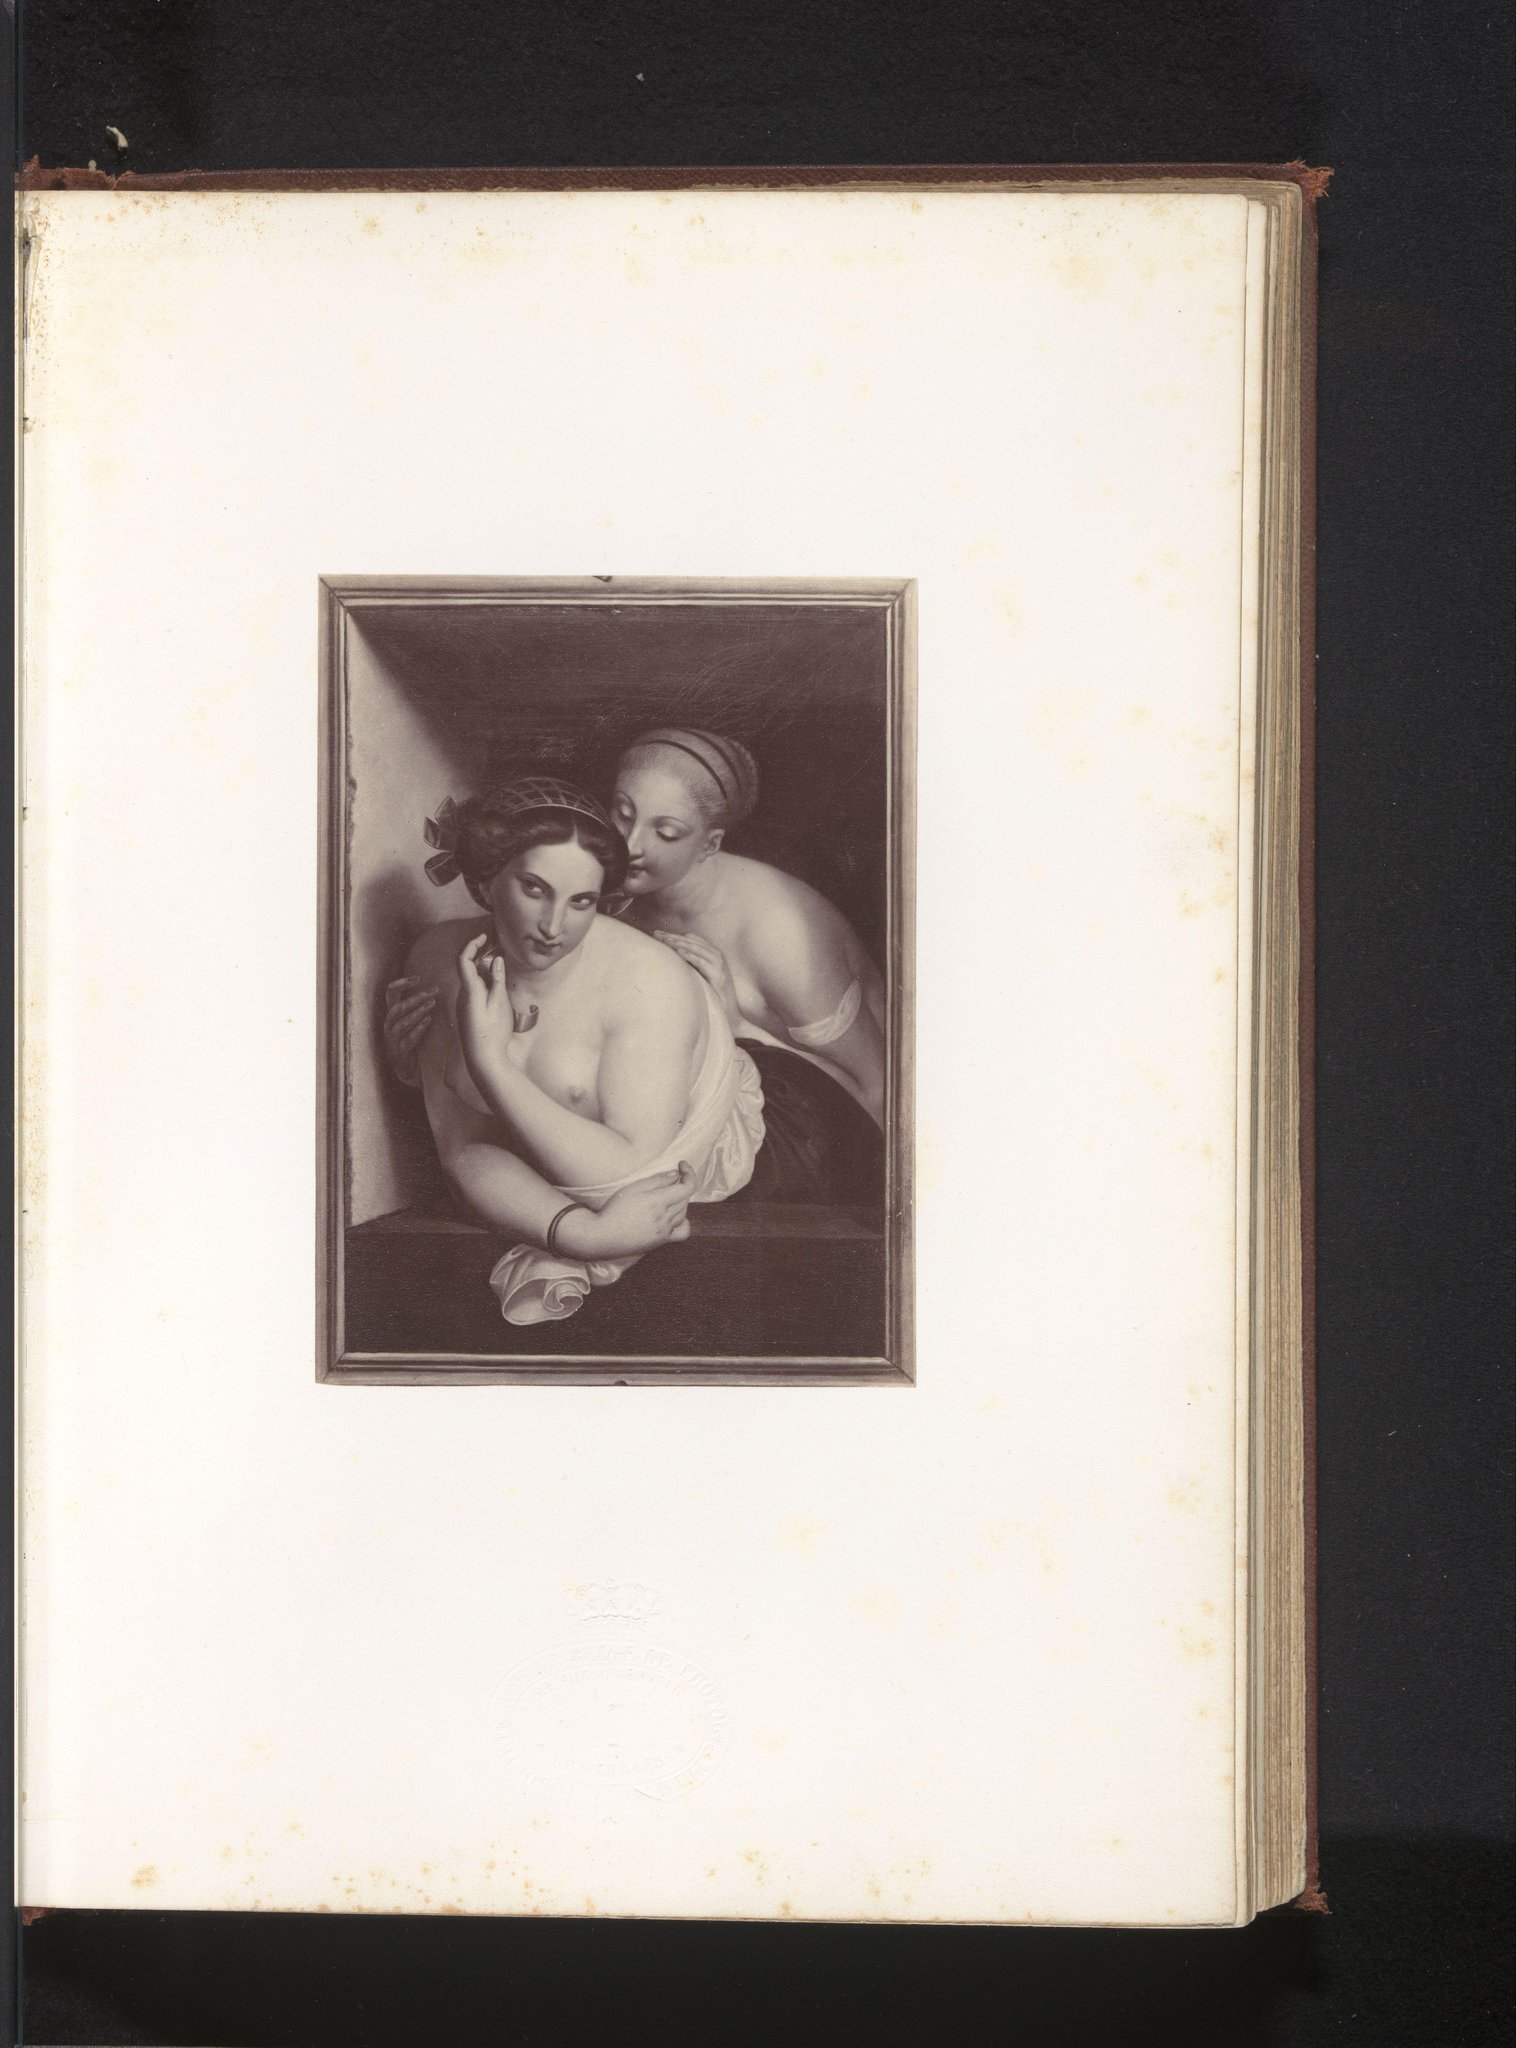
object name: photograph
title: Fotoreproductie van Het vertrouwen door Antoine Wiertz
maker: edmond fierlants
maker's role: fotograaf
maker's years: 1819-1869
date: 1863-1868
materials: photographic support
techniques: albumen print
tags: trust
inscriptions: check stamp: ‘SOCIÉTÉ ROYALE BELGE DE PHOTOGRAPHIE/ 69, RUE KEYENVELD/ BRUXELLES’